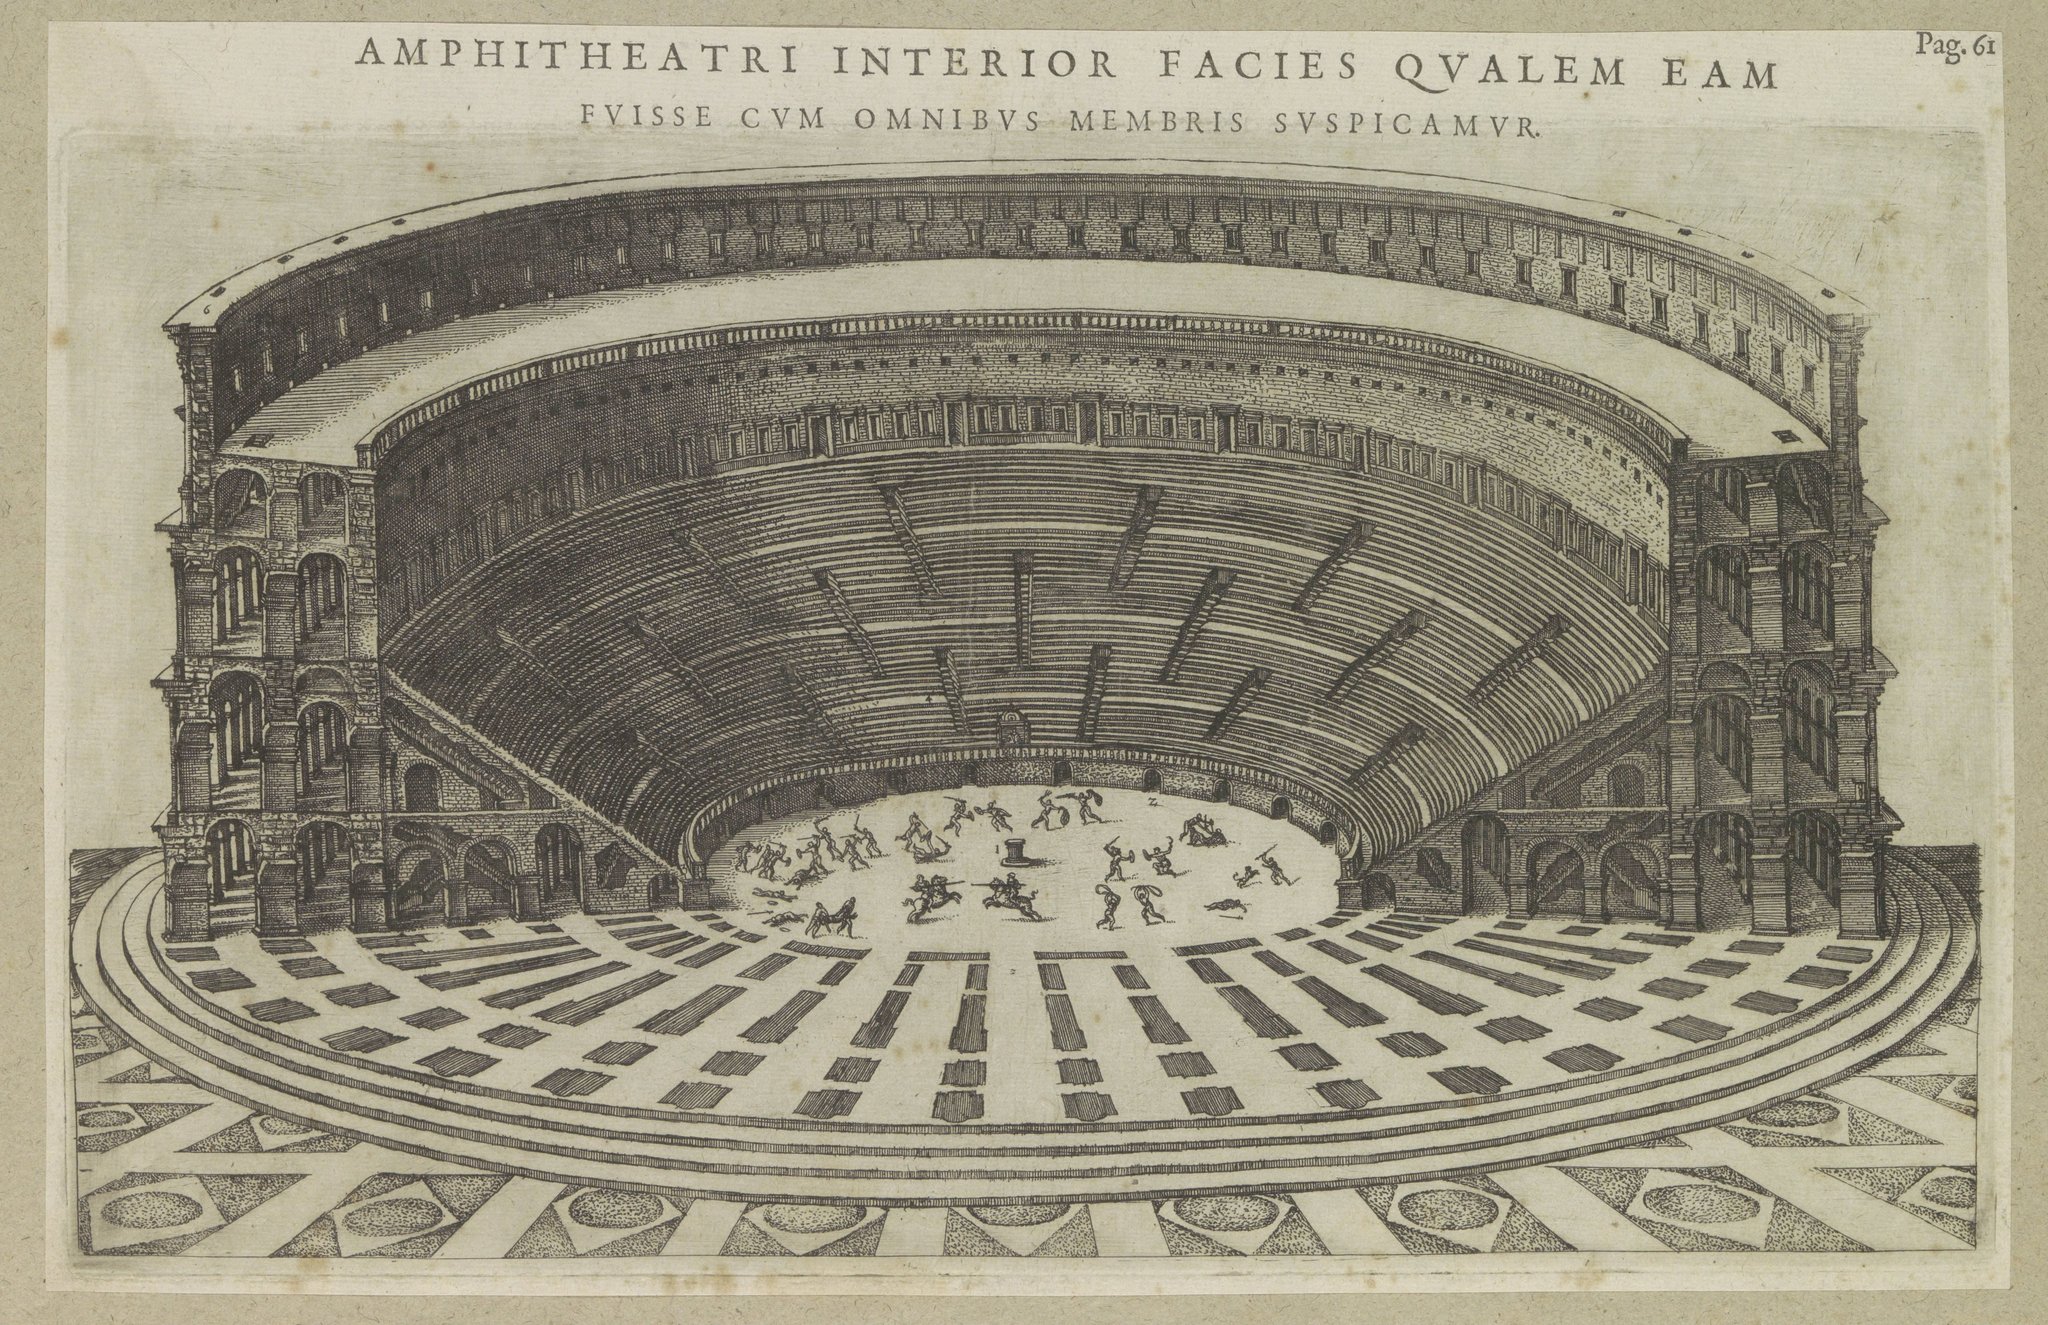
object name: album leaf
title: Interieur van een amfitheater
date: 1550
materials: paper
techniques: etching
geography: rome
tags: theatre (building) - aa - open-air performances, representation of real building (either existing or having existed)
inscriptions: date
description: Genummerd rechtsboven: Pag. 61. Titel boven de voorstelling. De prent maakt deel uit van een album.